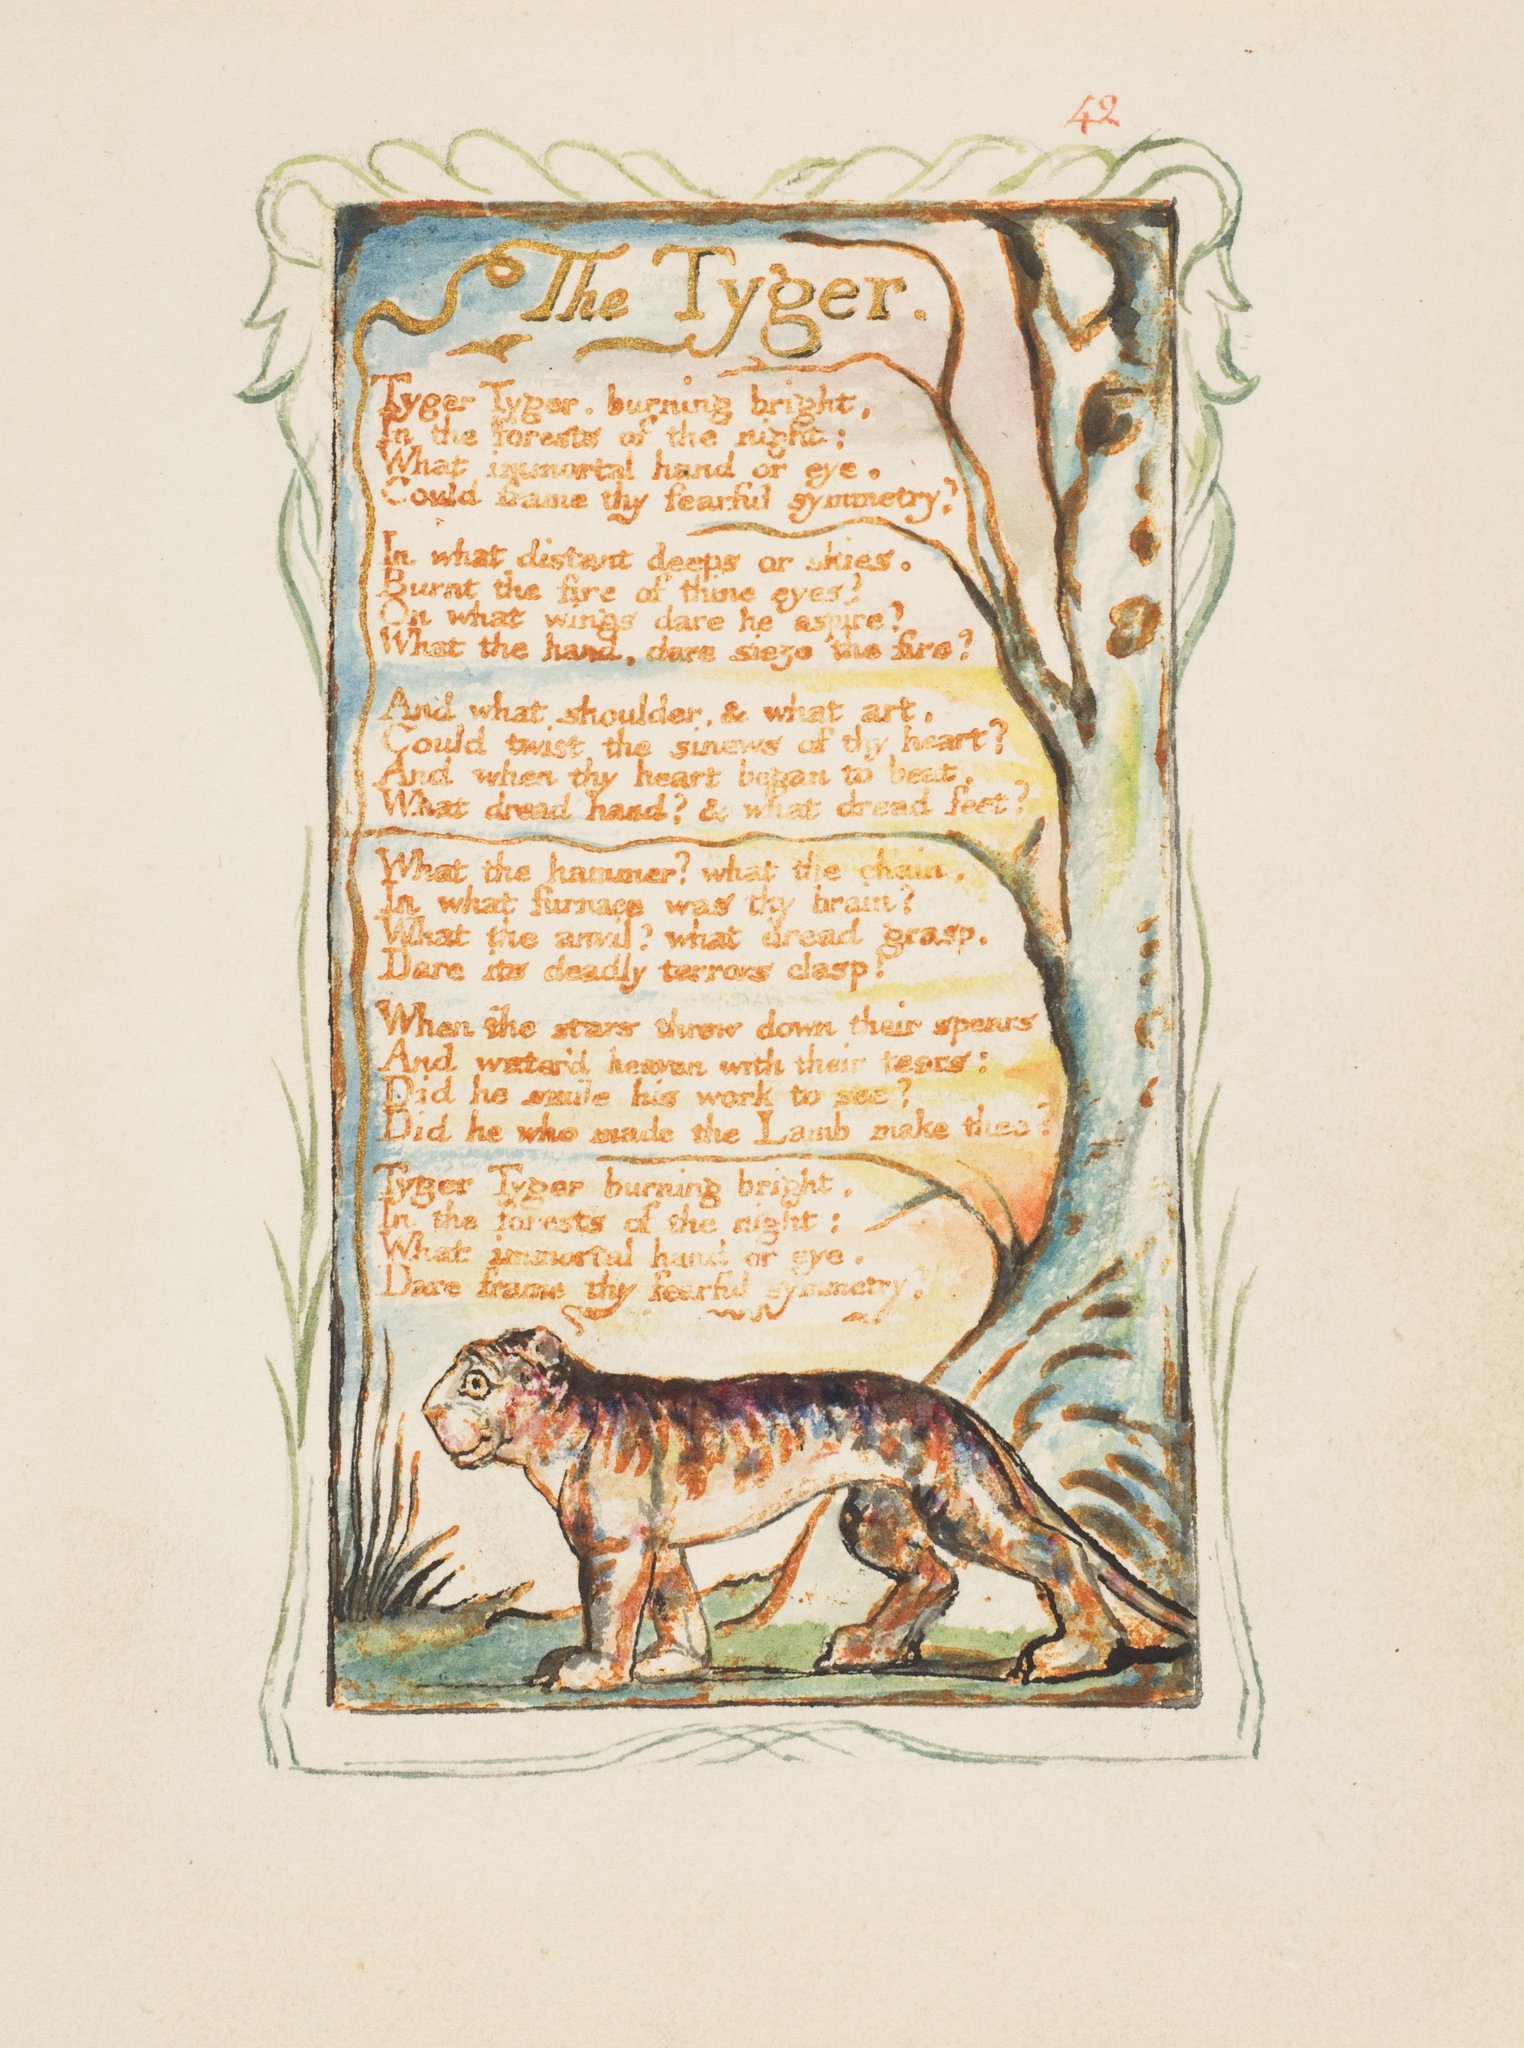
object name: print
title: Songs of Experience: The Tyger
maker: william blake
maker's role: artist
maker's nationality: british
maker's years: 1757-1827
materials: gold, ink, shell, watercolor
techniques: etching, hand coloring, printing, relief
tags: poetry,tigers